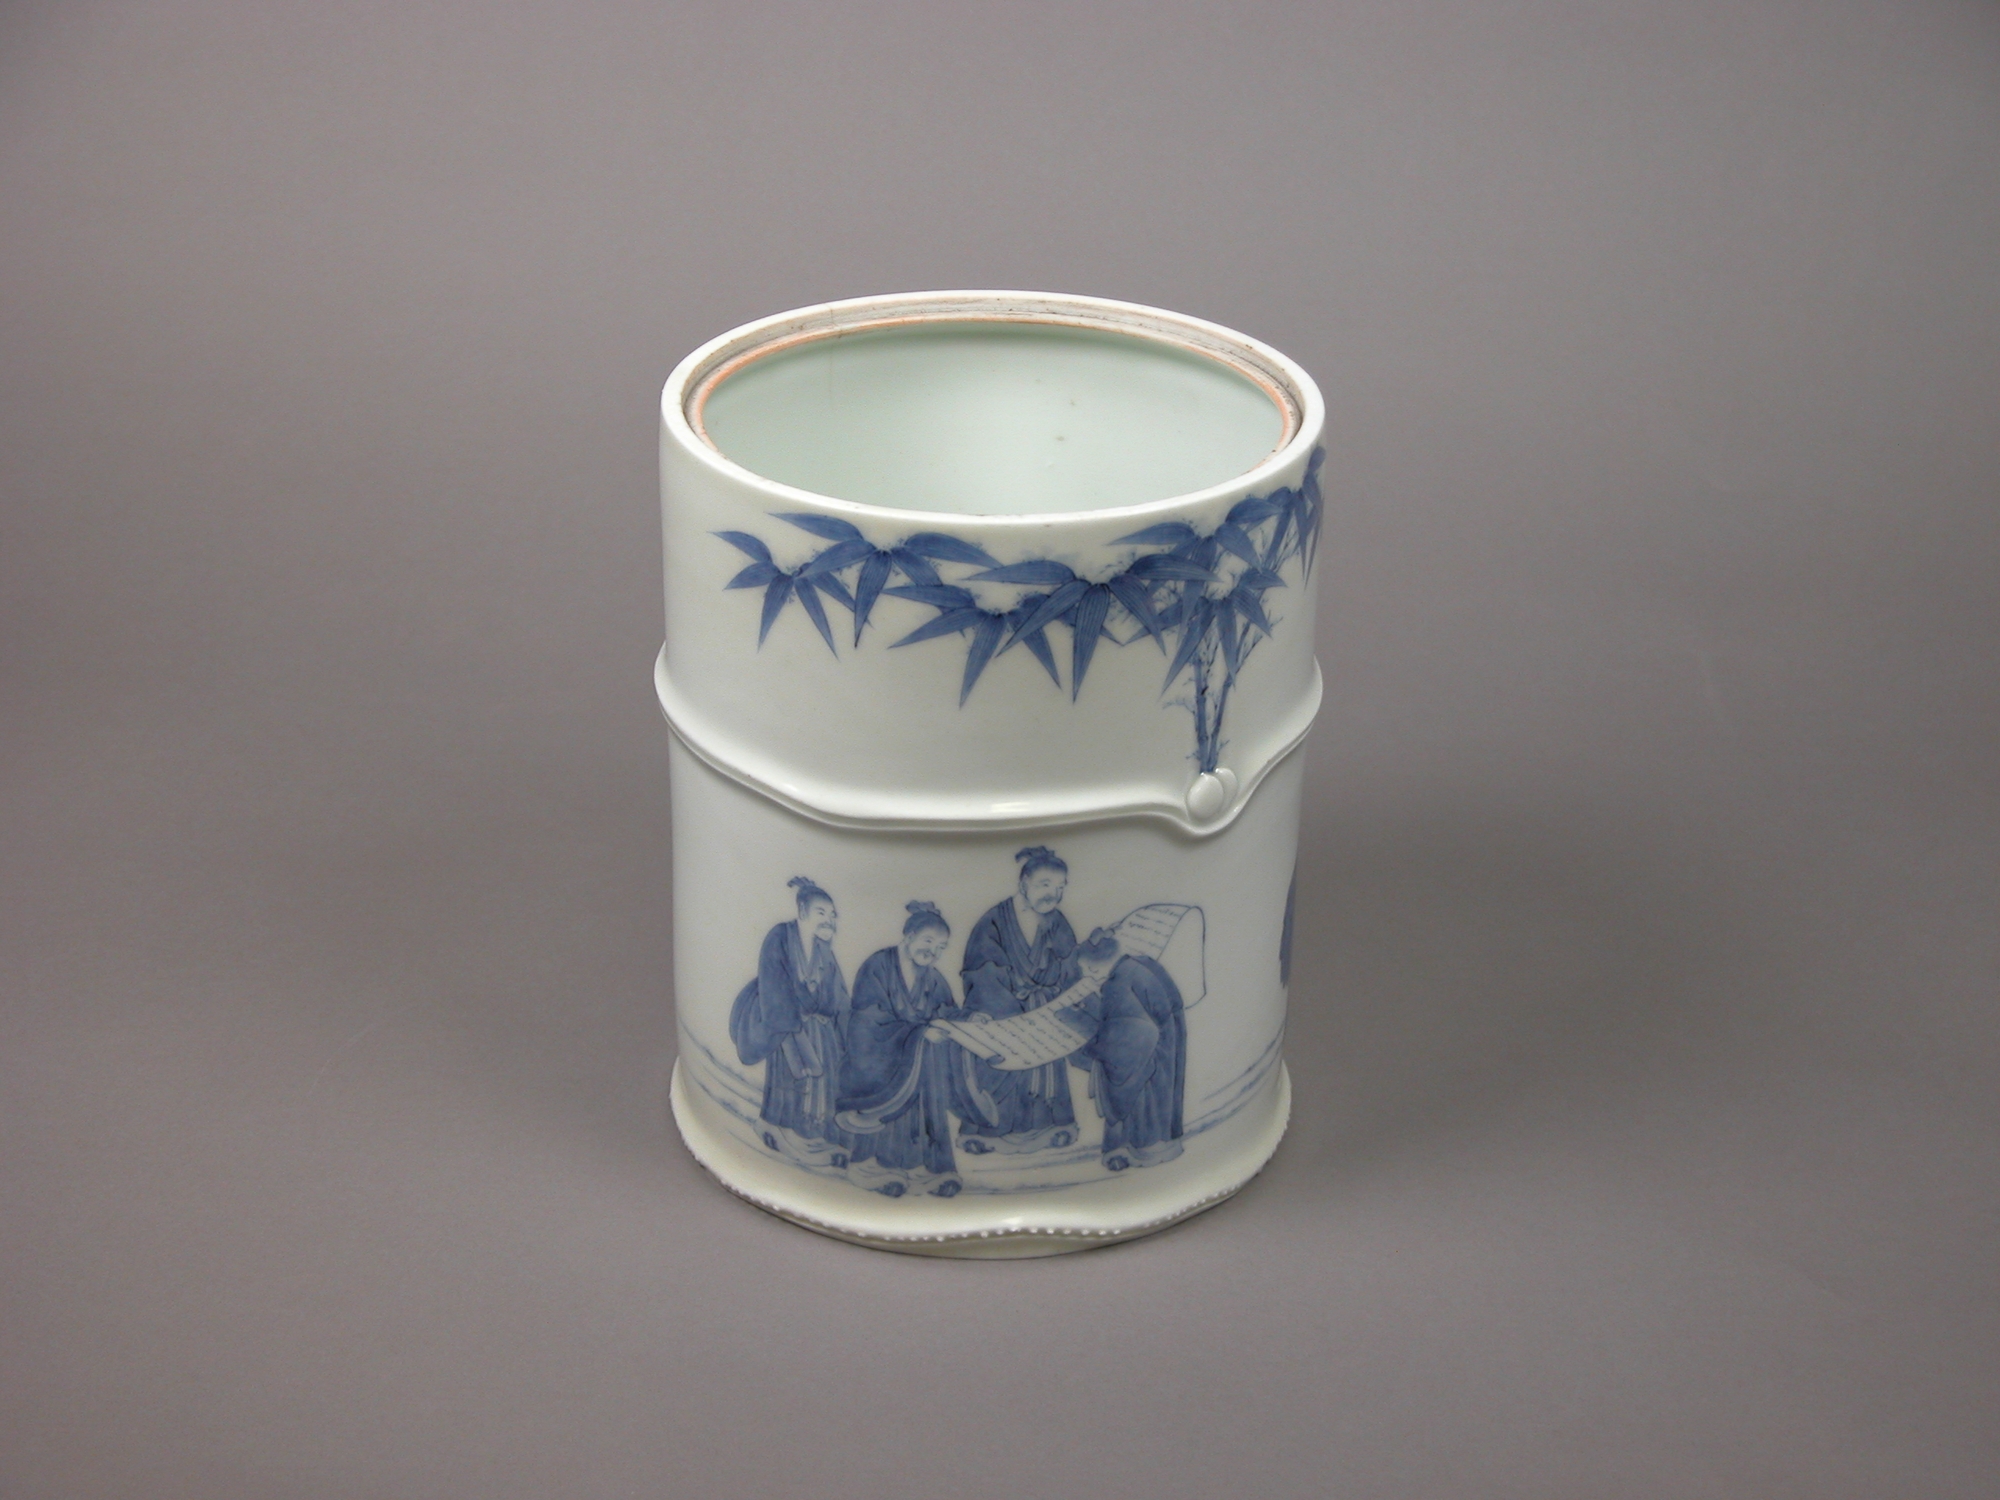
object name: water jar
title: Water Jar for the Tea Ceremony with Seven Sages of the Bamboo Grove Design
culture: japanese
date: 1701-1800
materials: lacquer, porcelain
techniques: underglaze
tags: men,reading,bamboo